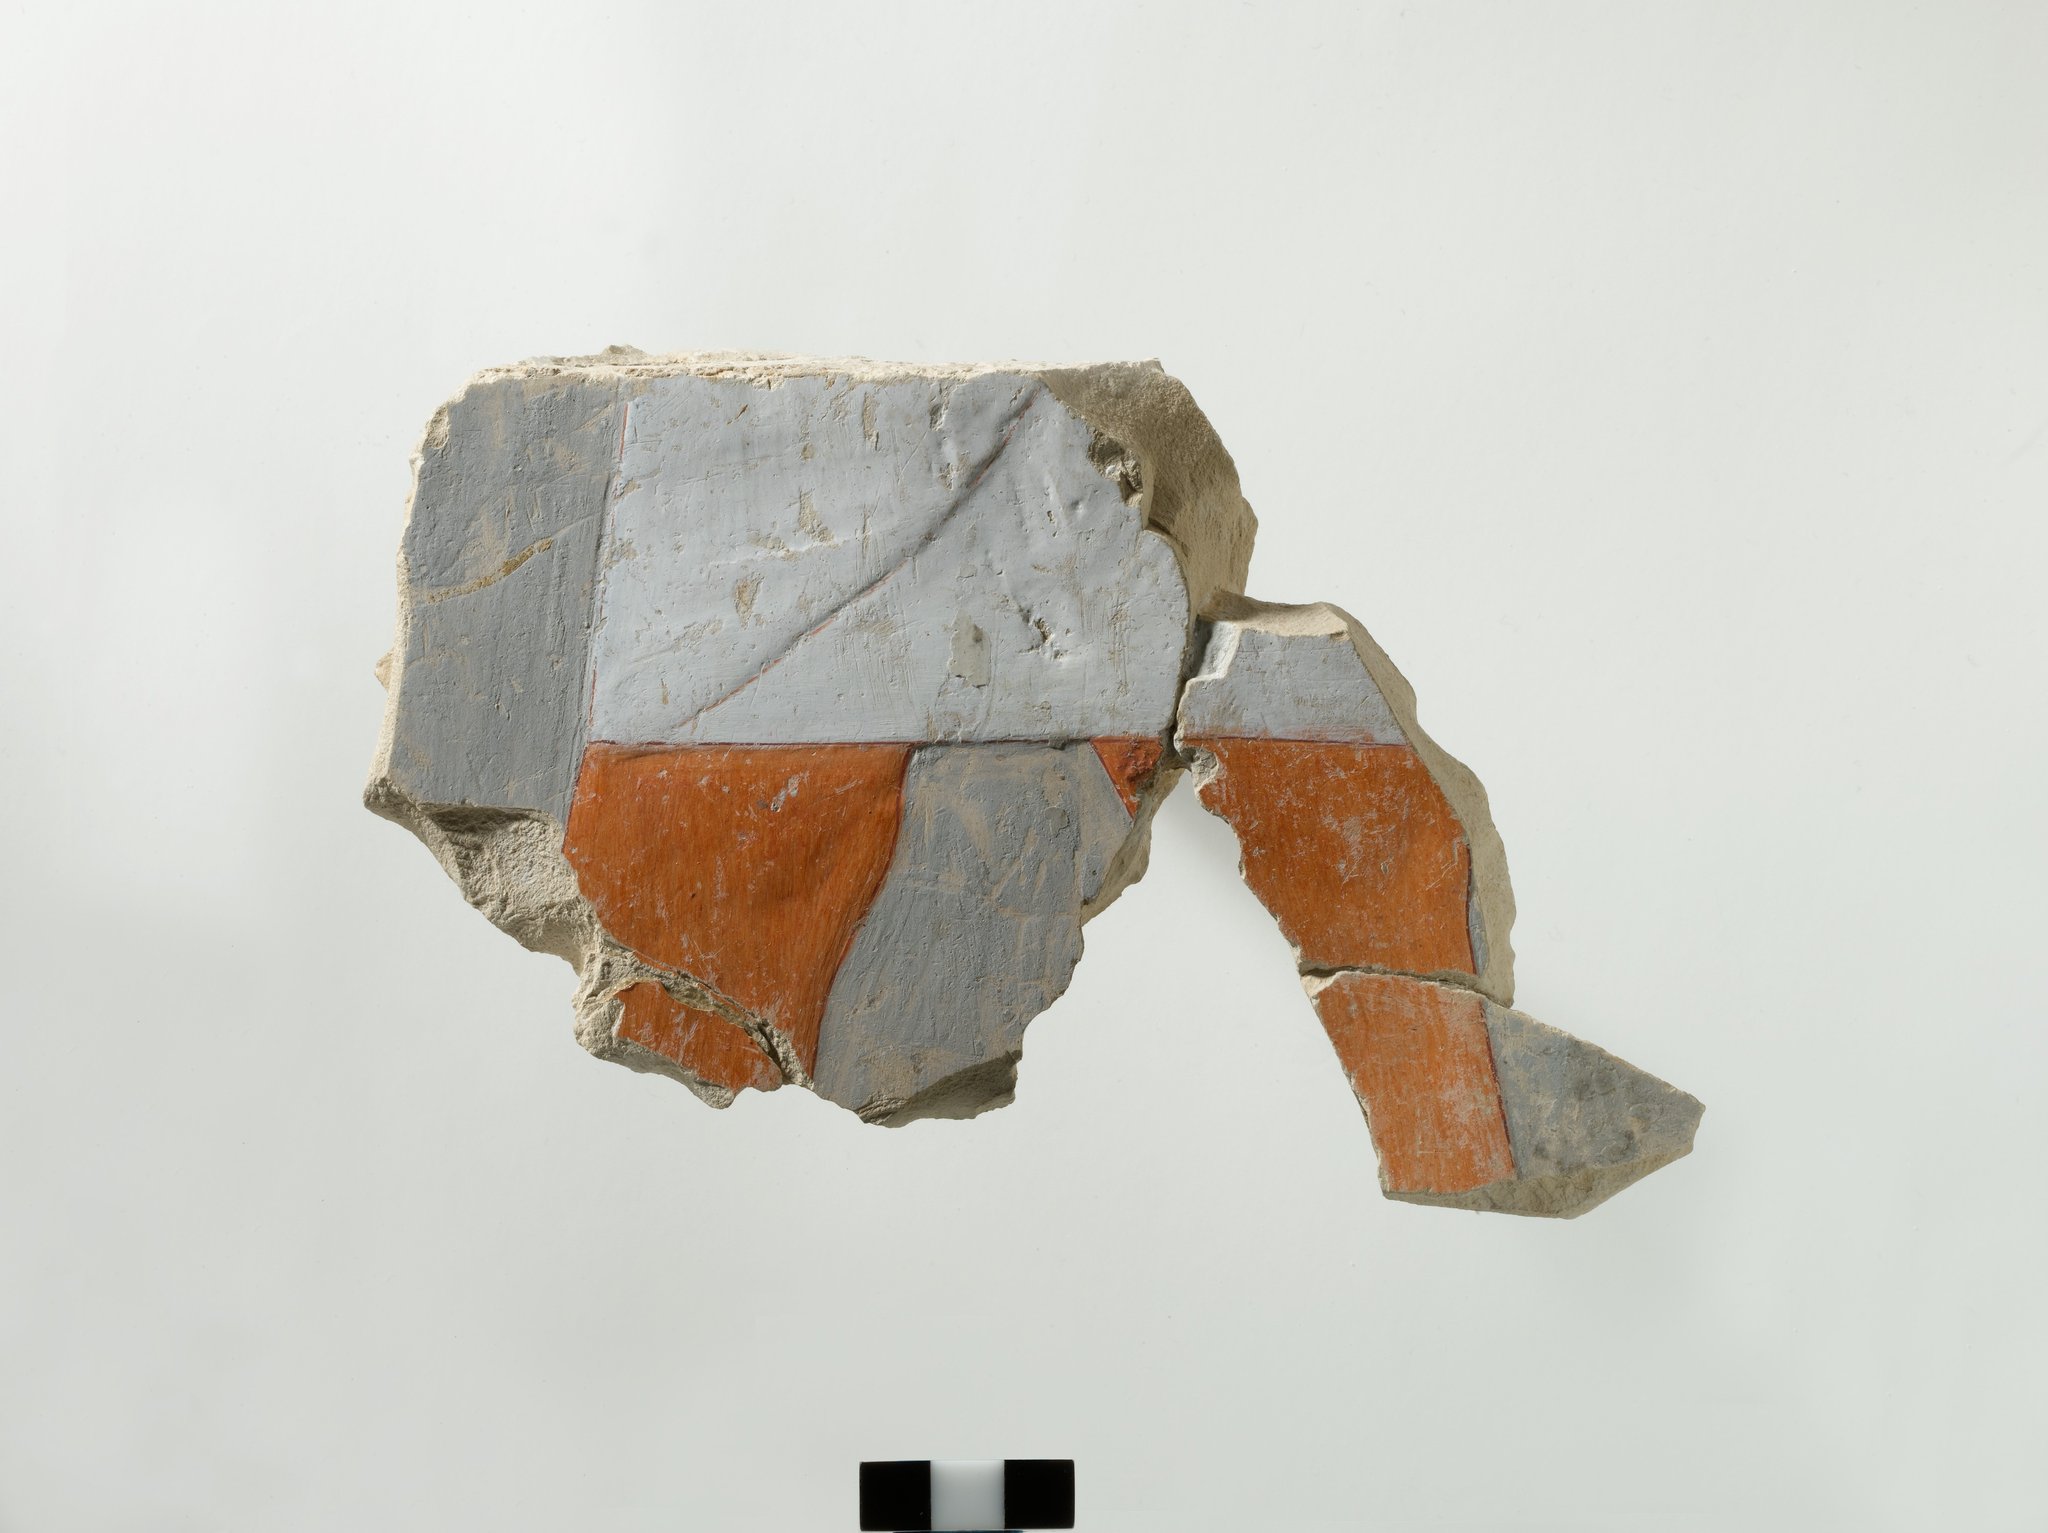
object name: relief fragment, tomb of meketre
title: Relief fragment from the tomb of Meketre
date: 1981-1975 BCE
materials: limestone, paint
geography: egypt